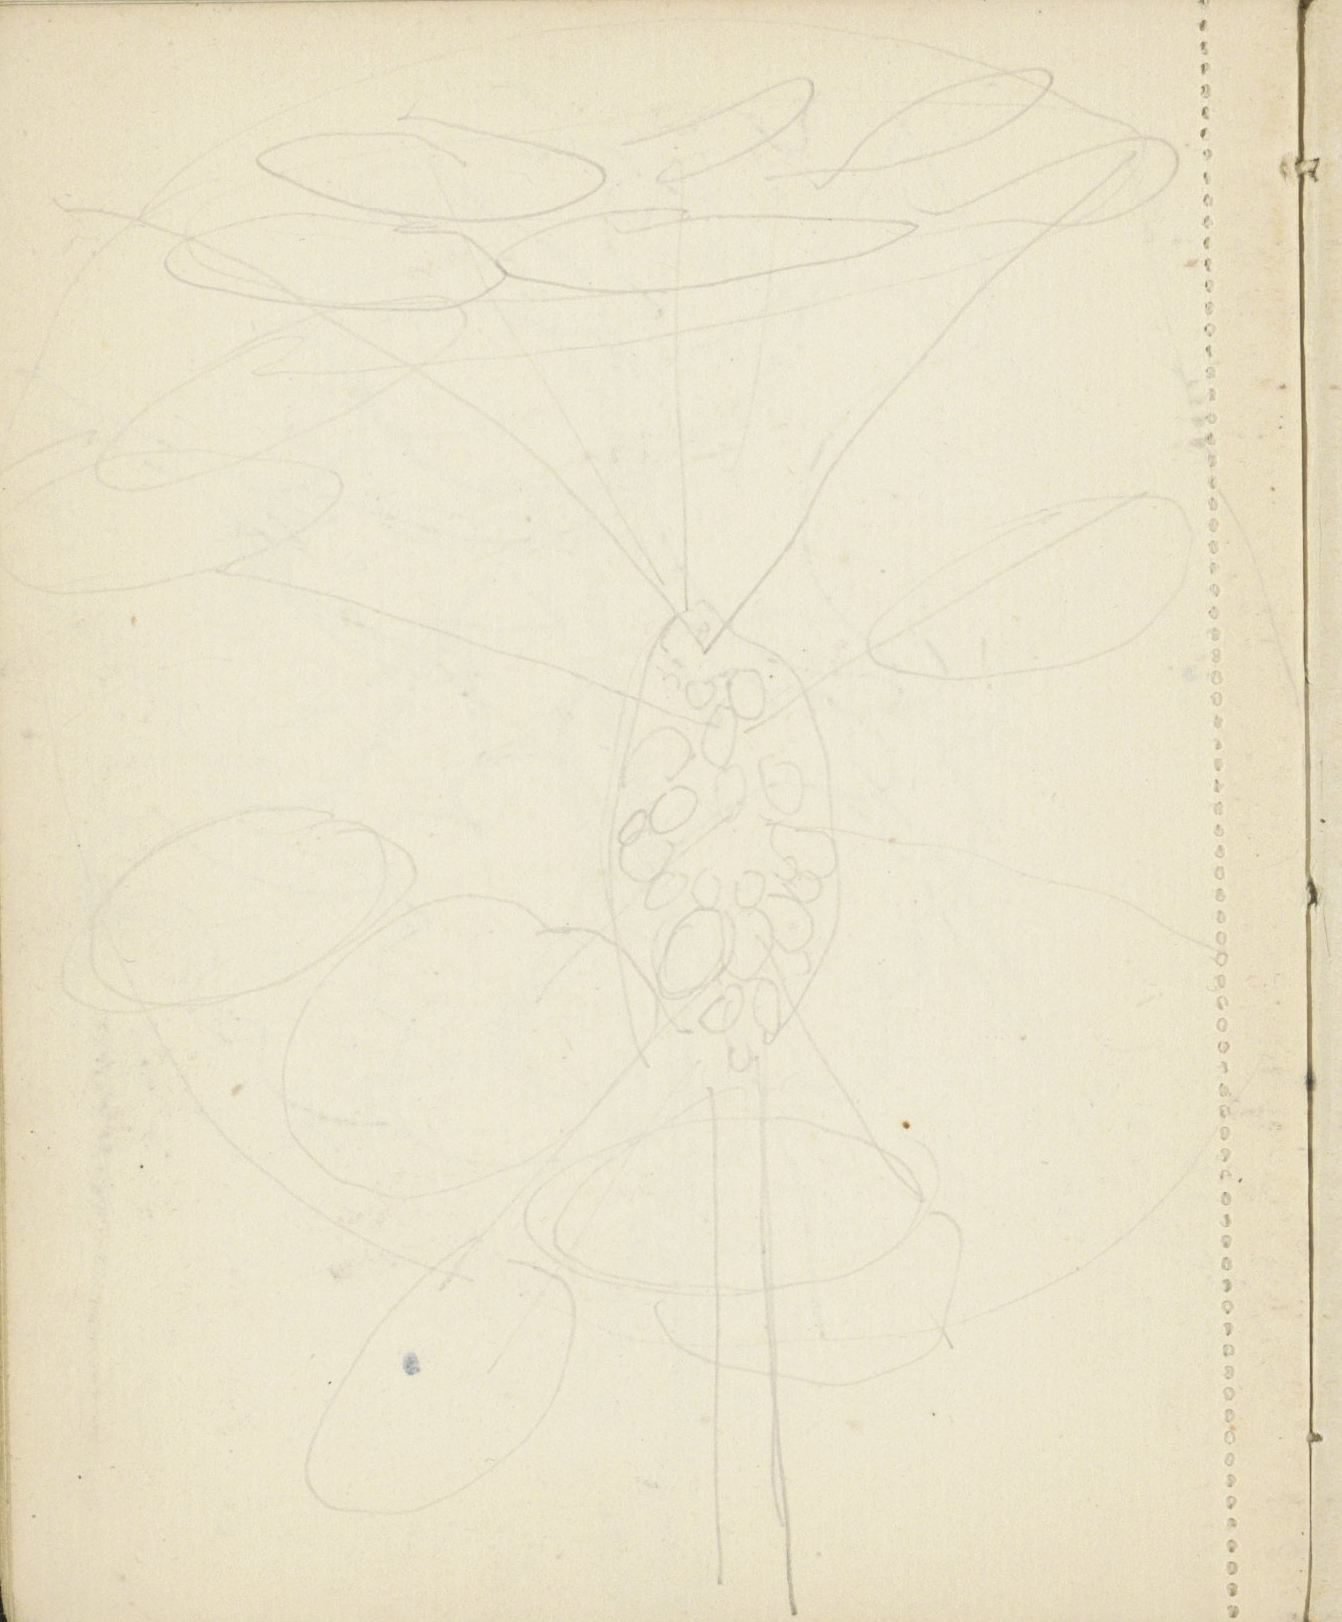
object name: sketchbook leaf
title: Bloem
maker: reijer stolk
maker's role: draughtsman, print maker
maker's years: 1896-1945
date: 1916-1945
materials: paper, pencil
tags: flowers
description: Blad 7 verso uit een schetsboek met 60 bladen.